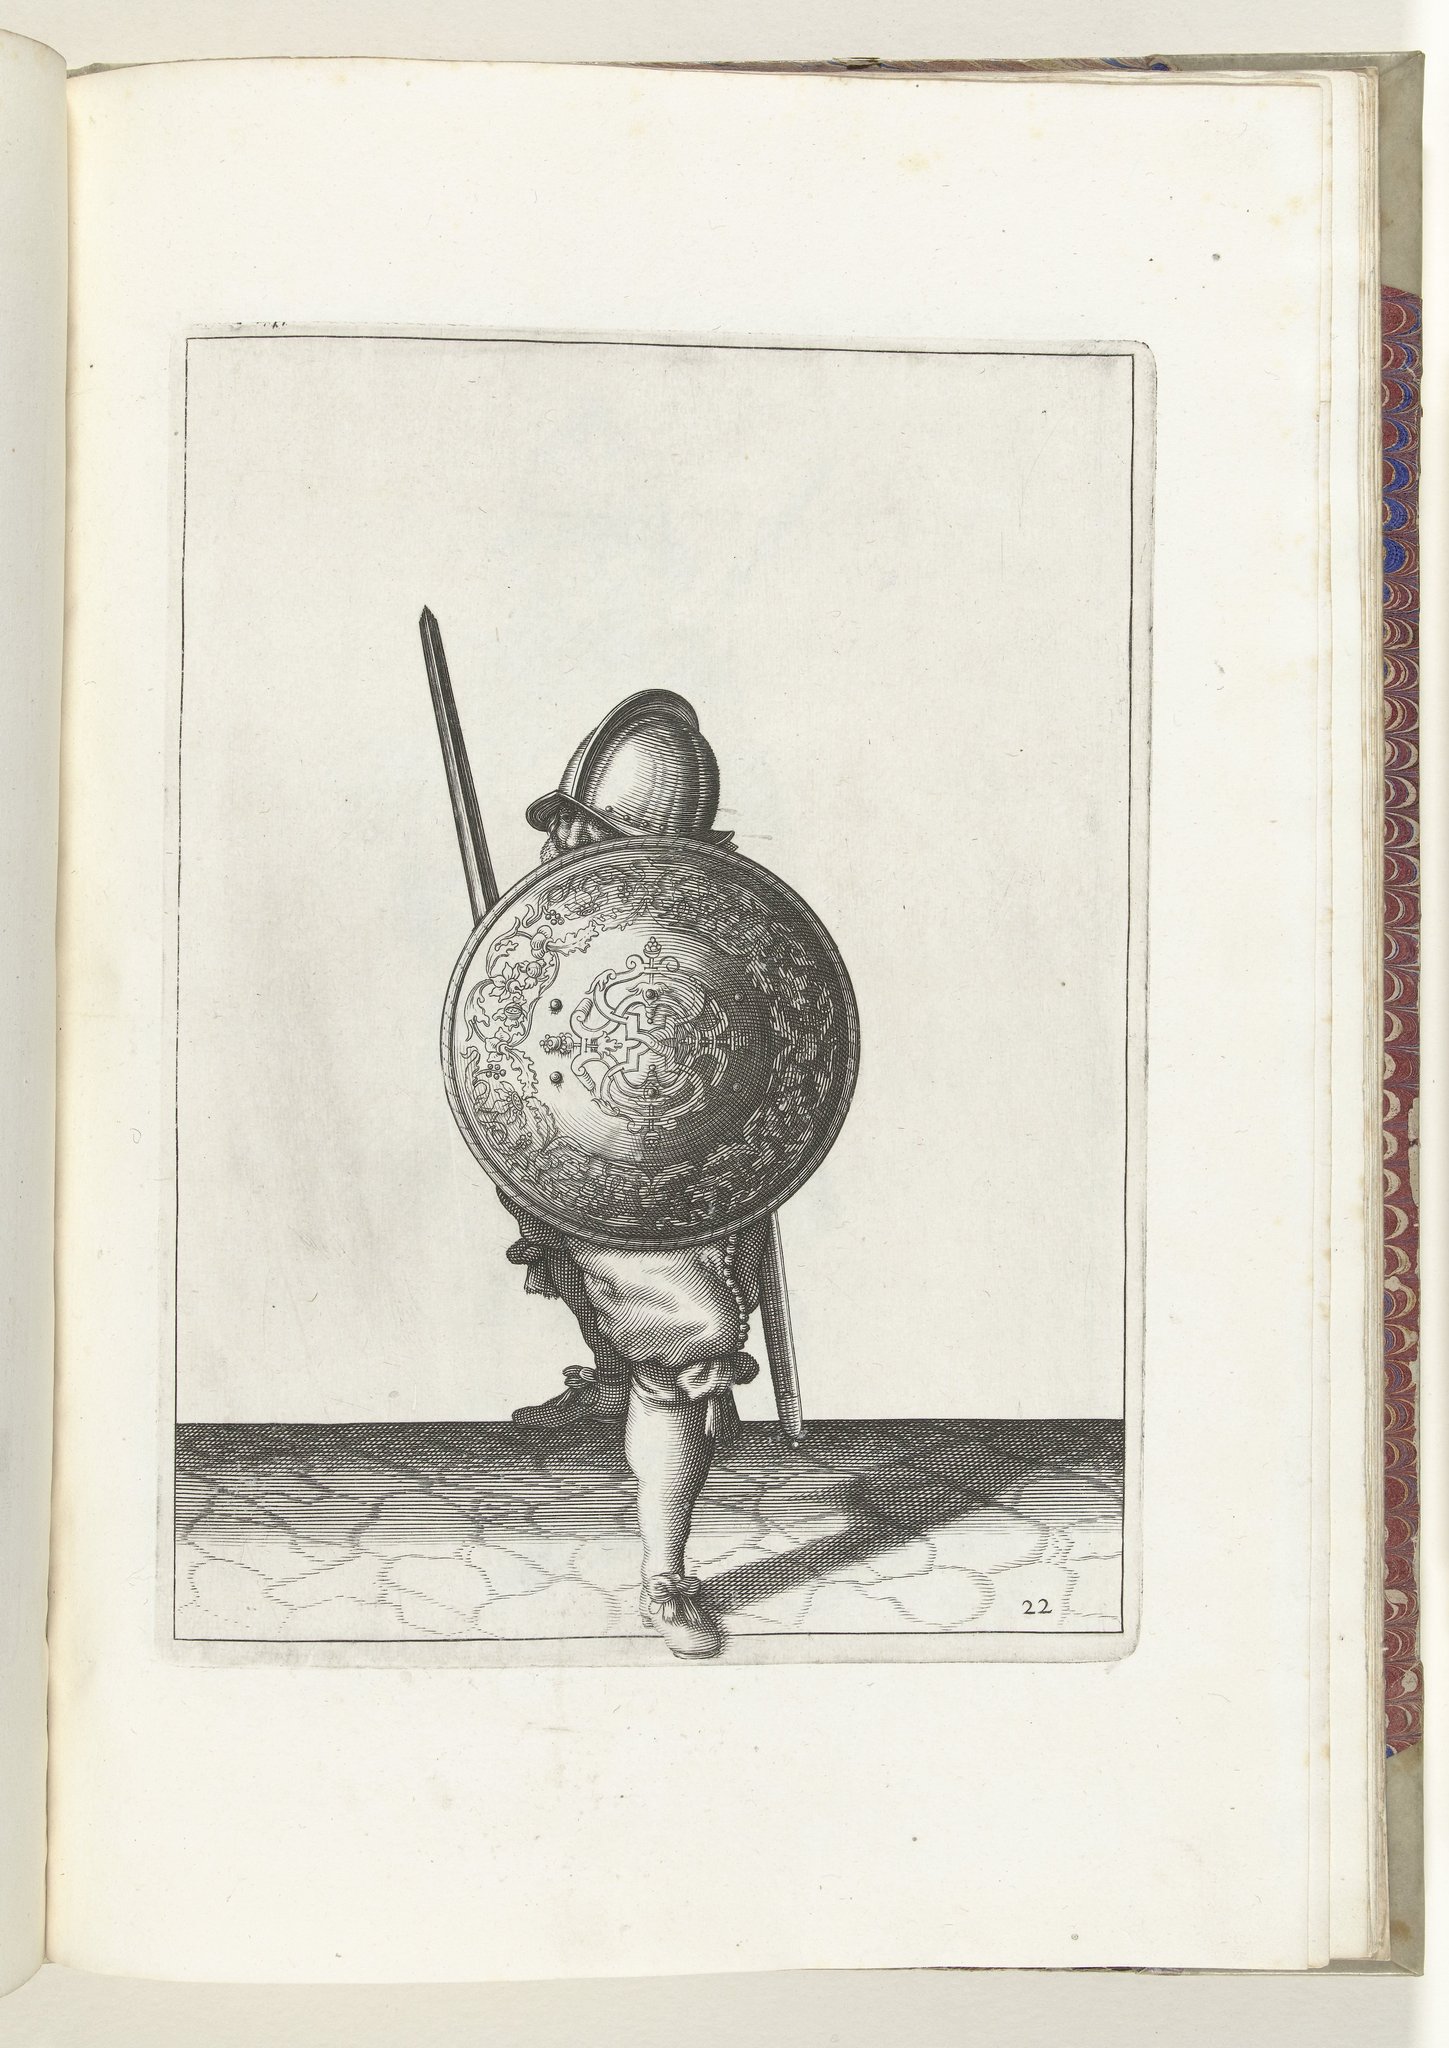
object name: print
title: De exercitie met schild en spies: de soldaat in een verdedigende houding met een voet naar voren en met zijn rapier en schild op de knie voor het lichaam, gezien van voren (nr. 22), 1618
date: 1616-1618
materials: paper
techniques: engraving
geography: northern netherlands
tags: maurice (prince of orange), handling of weapons ~ military training, weapons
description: Illustratie in: Adam van Breen, De Nassausche Wapen-Handelinge, van Schilt, Spies, Rappier ende Targe : beyde figuerlick afgebeelt, ende gestelt na de nieu ordening [van] ... Maurits van Nassau, 's-Gravenhage, [Aert Meuris] 1618, plaat nr. 22. In het exemplaar in de collectie van de Rijksmuseum Research Library (326 F 22).